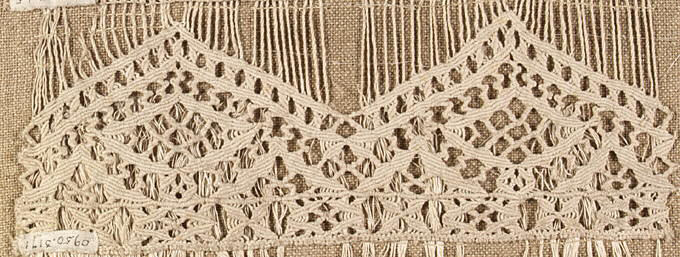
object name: fragment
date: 1701-1800